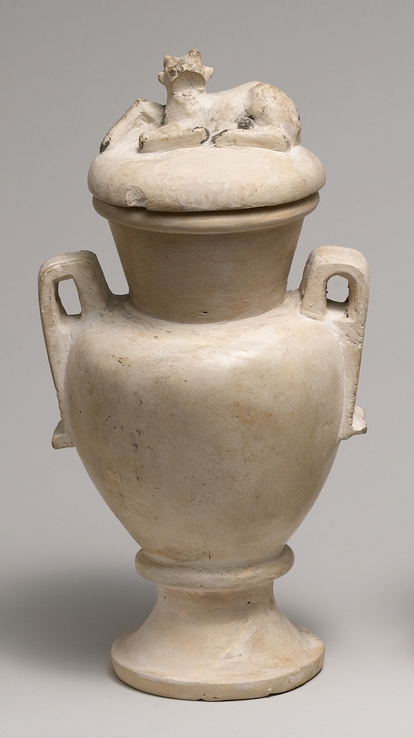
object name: jar and lid, calf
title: Two Handled Jar and Lid decorated with a Resting Ibix Calf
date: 1390-1352 BCE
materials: limestone, paint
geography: egypt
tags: animals